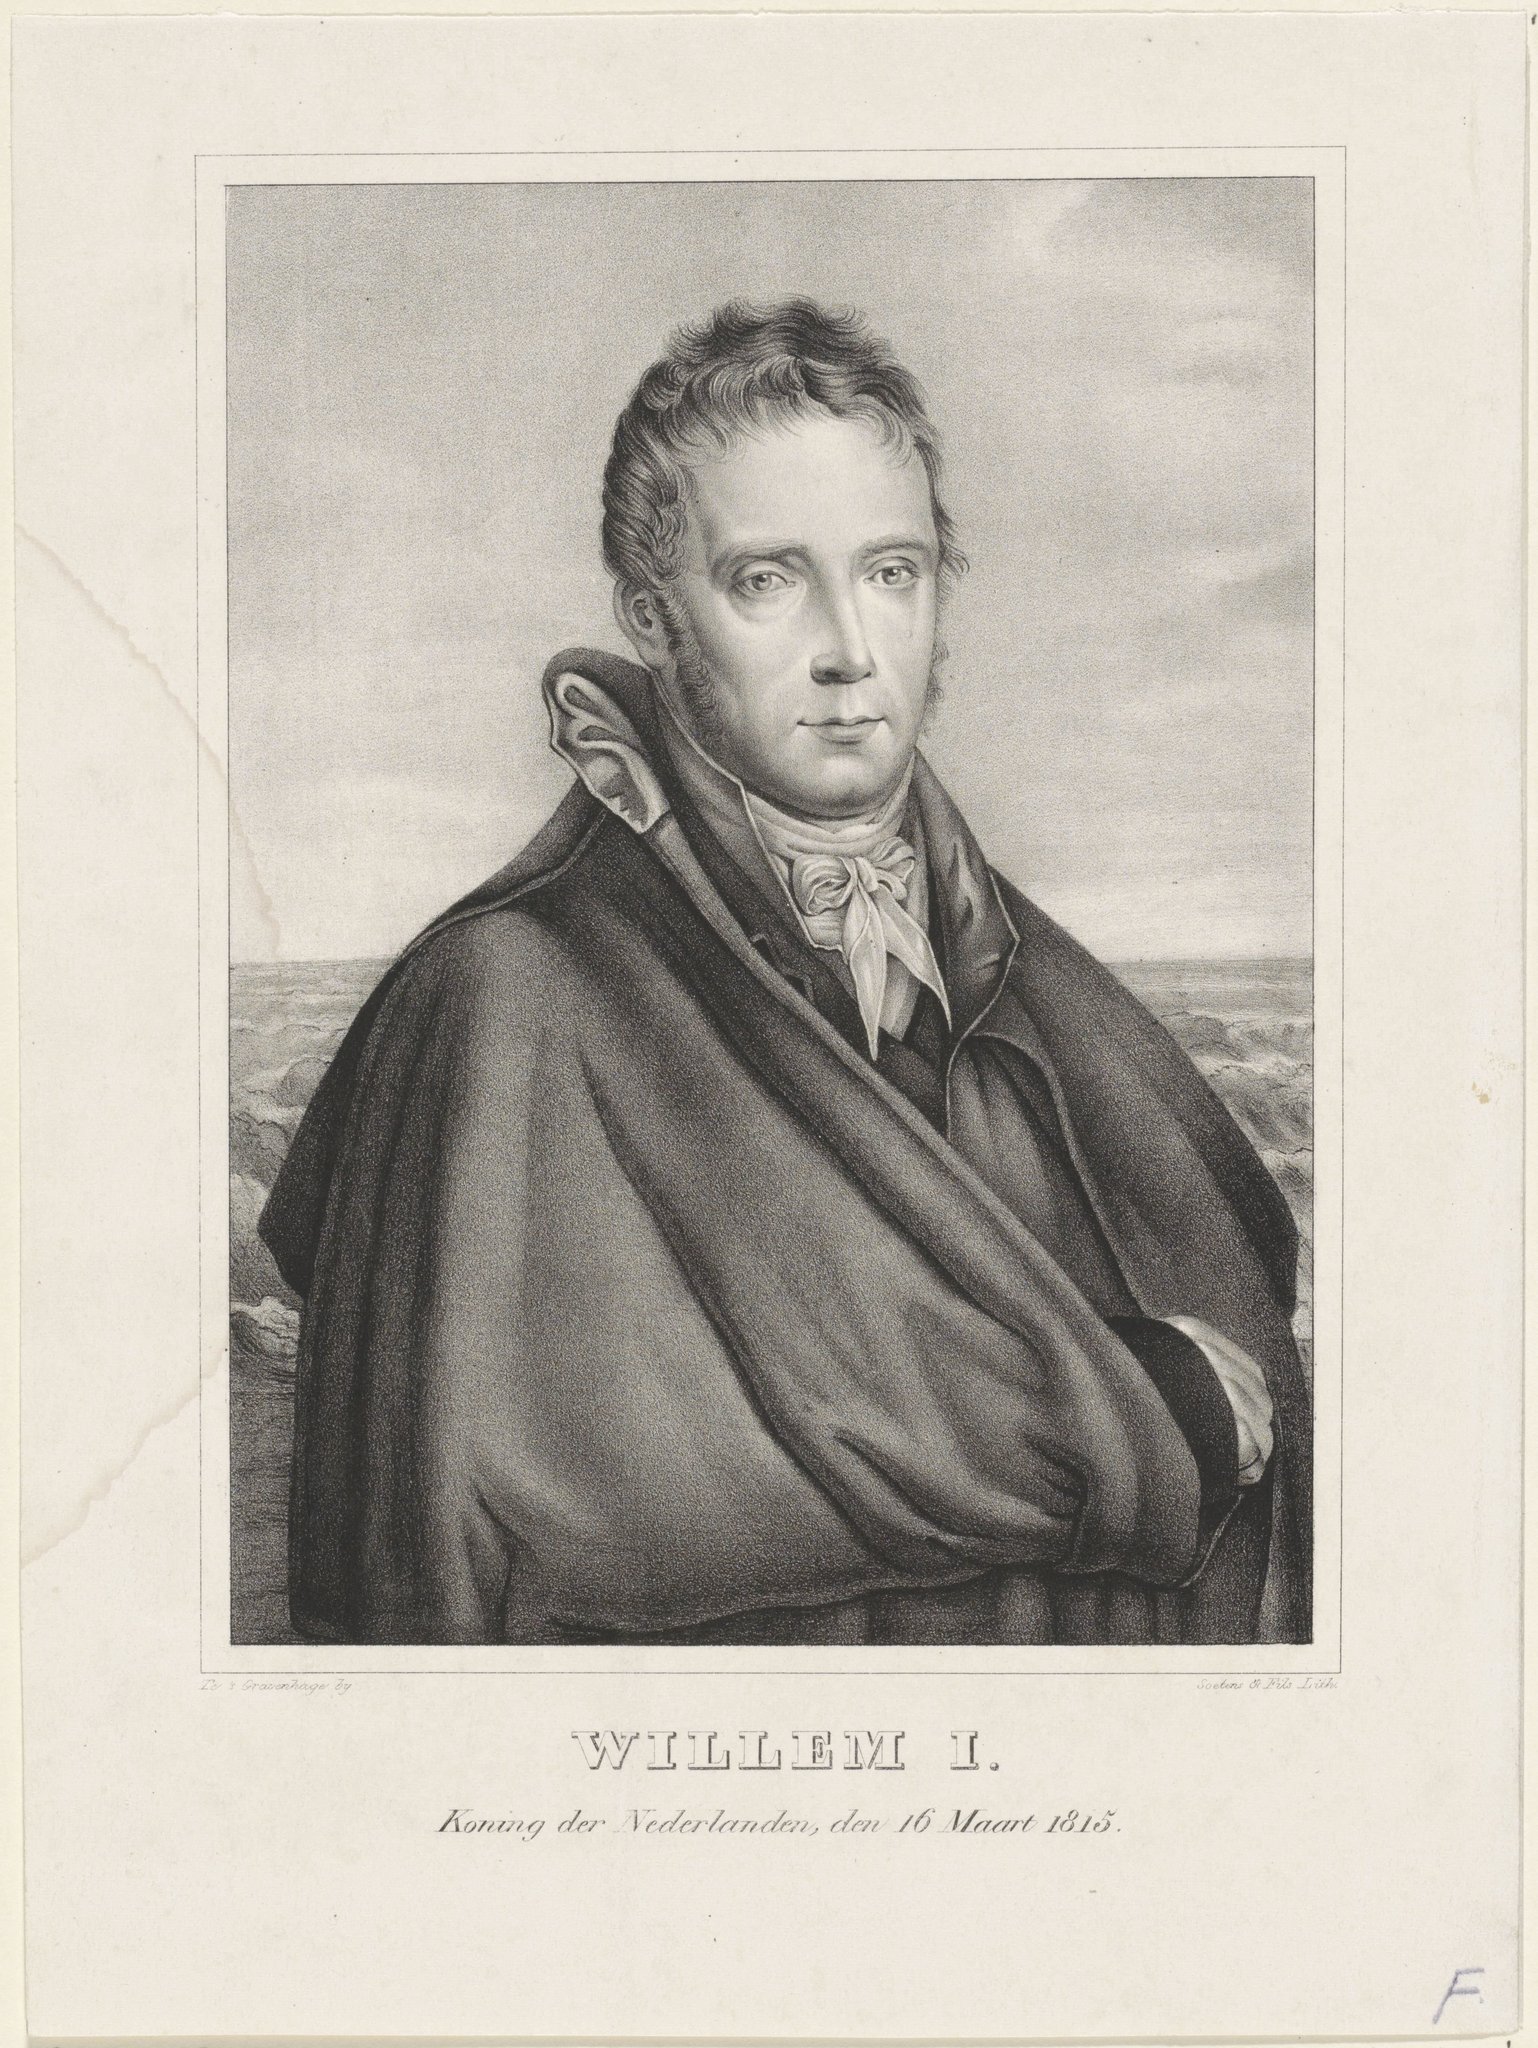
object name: print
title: Portret van Willem I Frederik, koning der Nederlanden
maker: Anonymous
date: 1837-1840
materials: paper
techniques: lithograph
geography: netherlands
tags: the hague, berlin, william i of the netherlands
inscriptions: collector's mark: Lugt 2228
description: De hier vermelde titel verwijst naar de hoogst verkregen titel van de geportretteerde, niet per se naar de titel die de geportretteerde op deze voorstelling draagt.